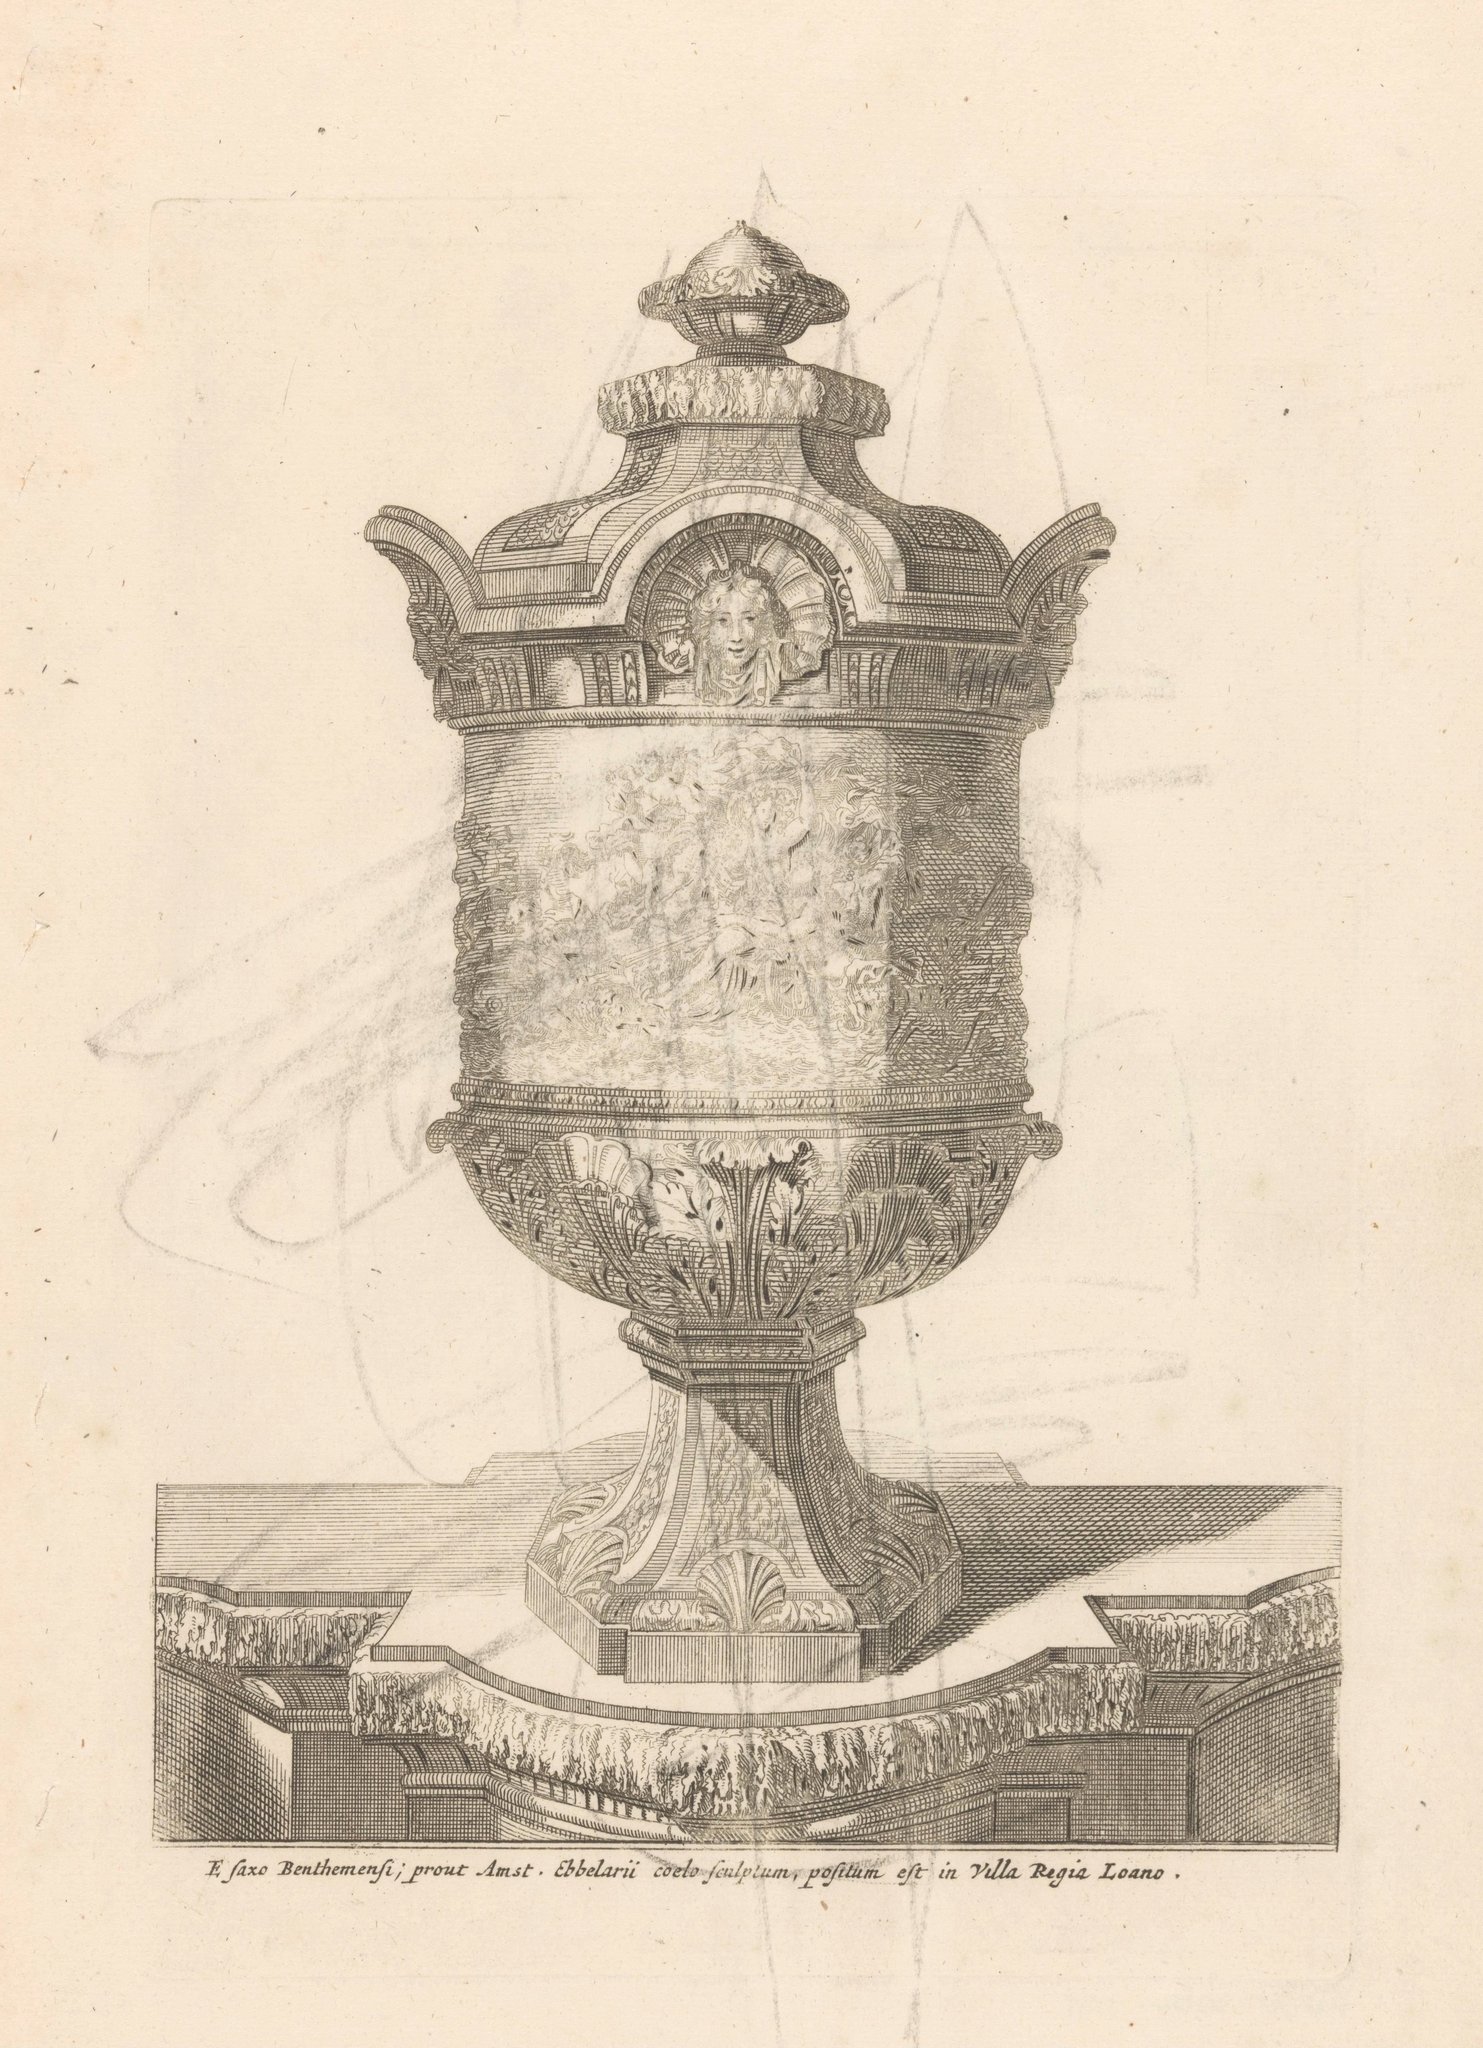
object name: print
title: Tuinvazen van Paleis Het Loo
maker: Anonymous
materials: paper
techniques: etching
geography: netherlands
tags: triumph of amphitrite, garden vase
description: Vaas op een achthoekige voet met deksel. Op het cilindervormig lichaam van de vaas de triomf van Amphitrite. In de ondermarge een Latijnse tekst.